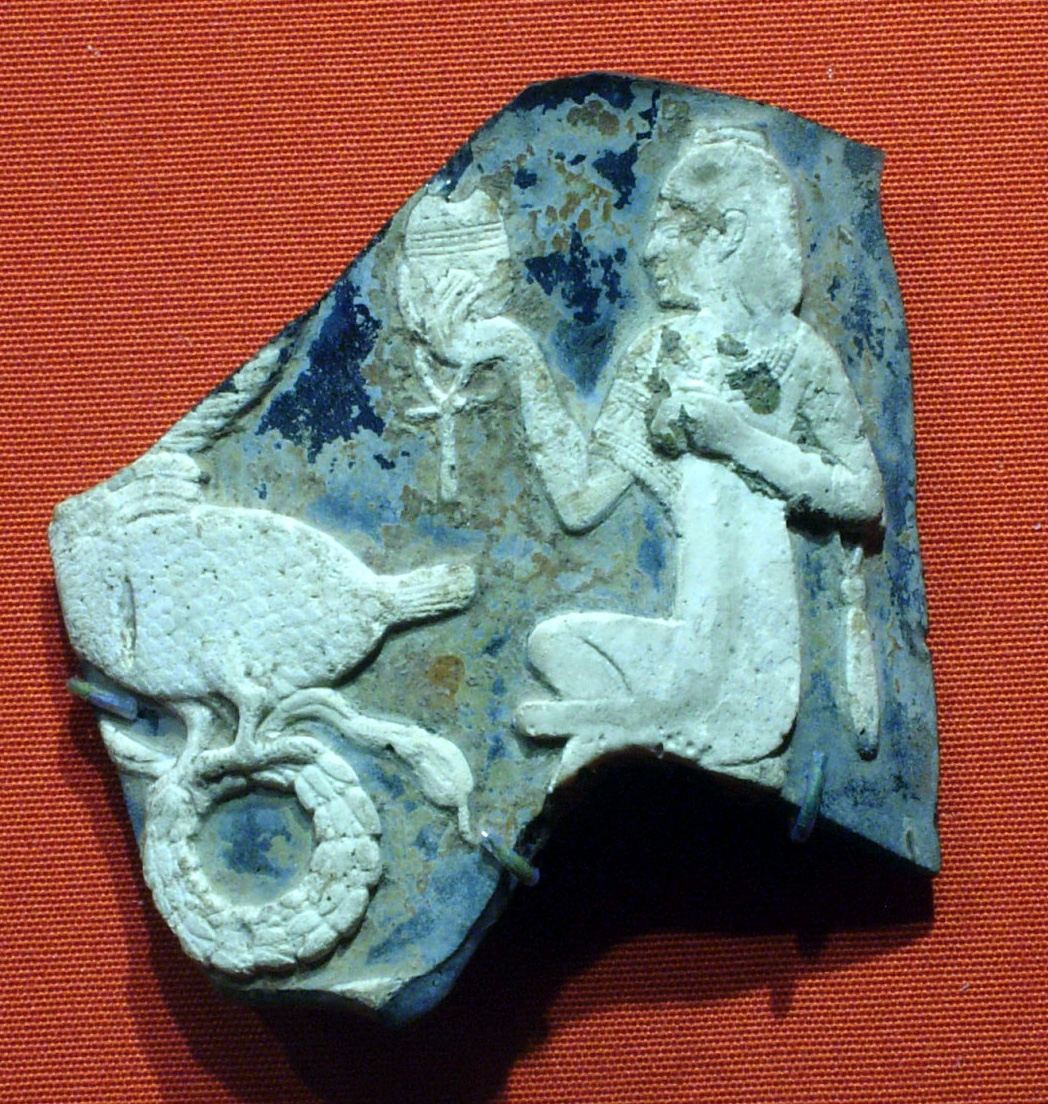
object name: cameo, egyptianizing scene from cup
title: Cameo fragment from a kantharos (drinking cup) with an Egyptianizing scene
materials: glass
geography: egypt